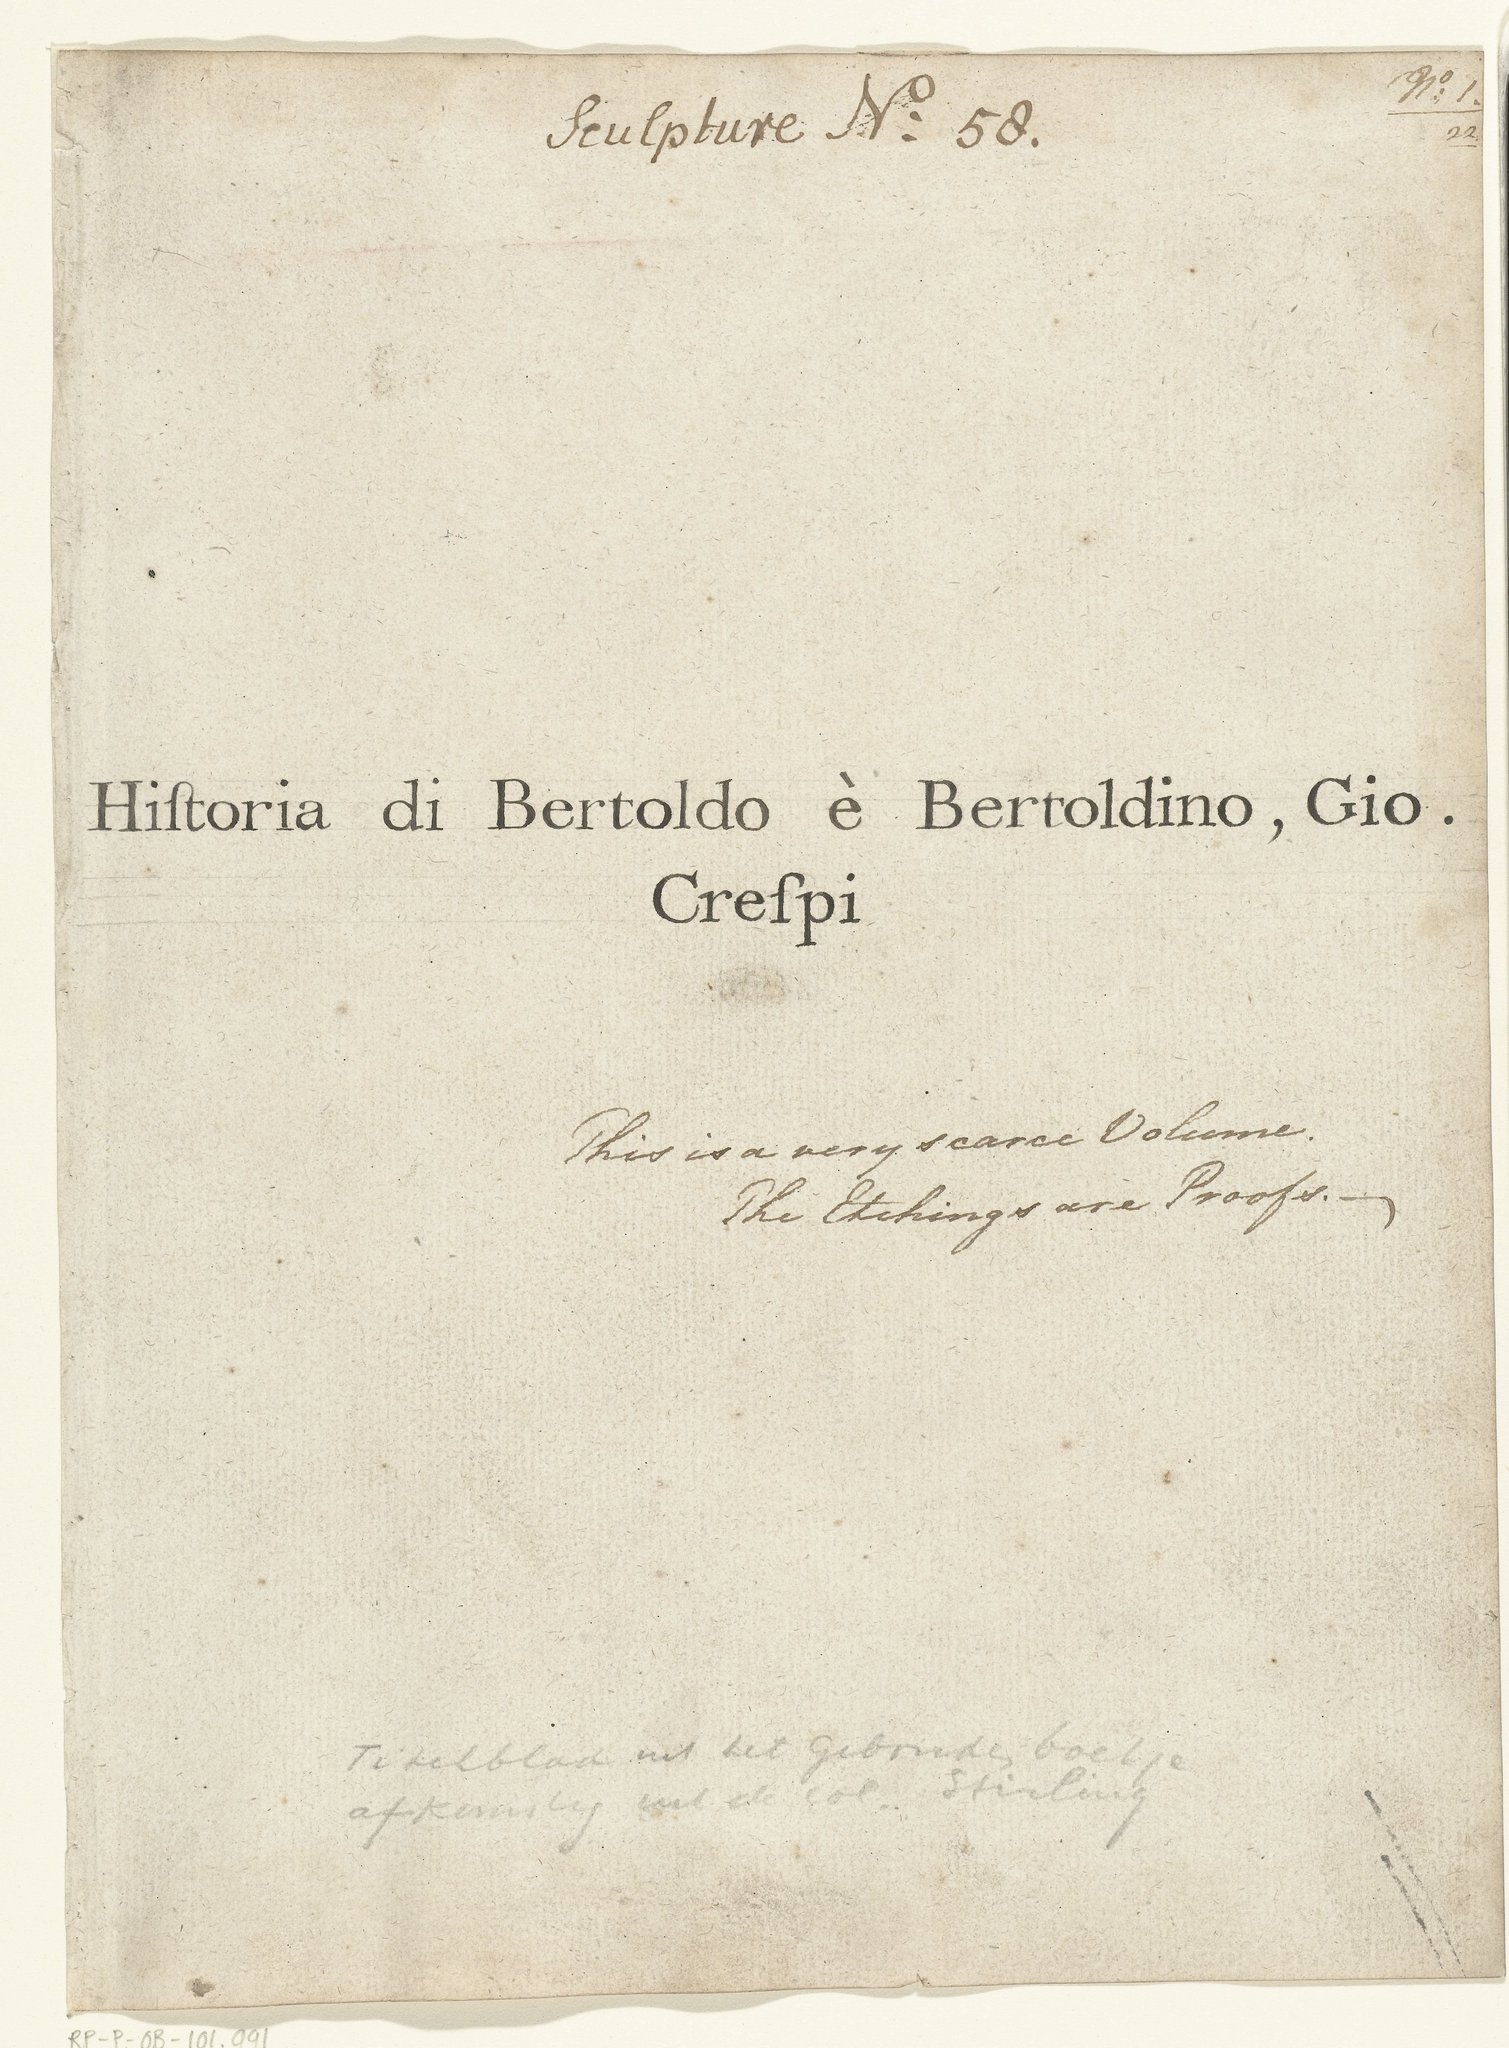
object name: titelblad, titelpagina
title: Historia di Bertoldo è Bertoldino, Gio. Crespi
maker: Anonymous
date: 1710-1715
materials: paper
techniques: pen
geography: italy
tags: title-page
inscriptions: collector's mark: Lugt 2228, inscription: ‘this is a very scarce Volume The Etchings are Proofs.’, inscription: ‘Titelblad uit het gebruiksboekje afkomstig uit de col. Stirling’, inscription: ‘Sculpture N. 58’, number: ‘No. 1. 22’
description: Titelblad van de Historie van Bertoldo, Bertoldino en Cacasenno, met prenten van Guiseppe Maria Crespi, naar de boeken van Guilio Cesare Croce.